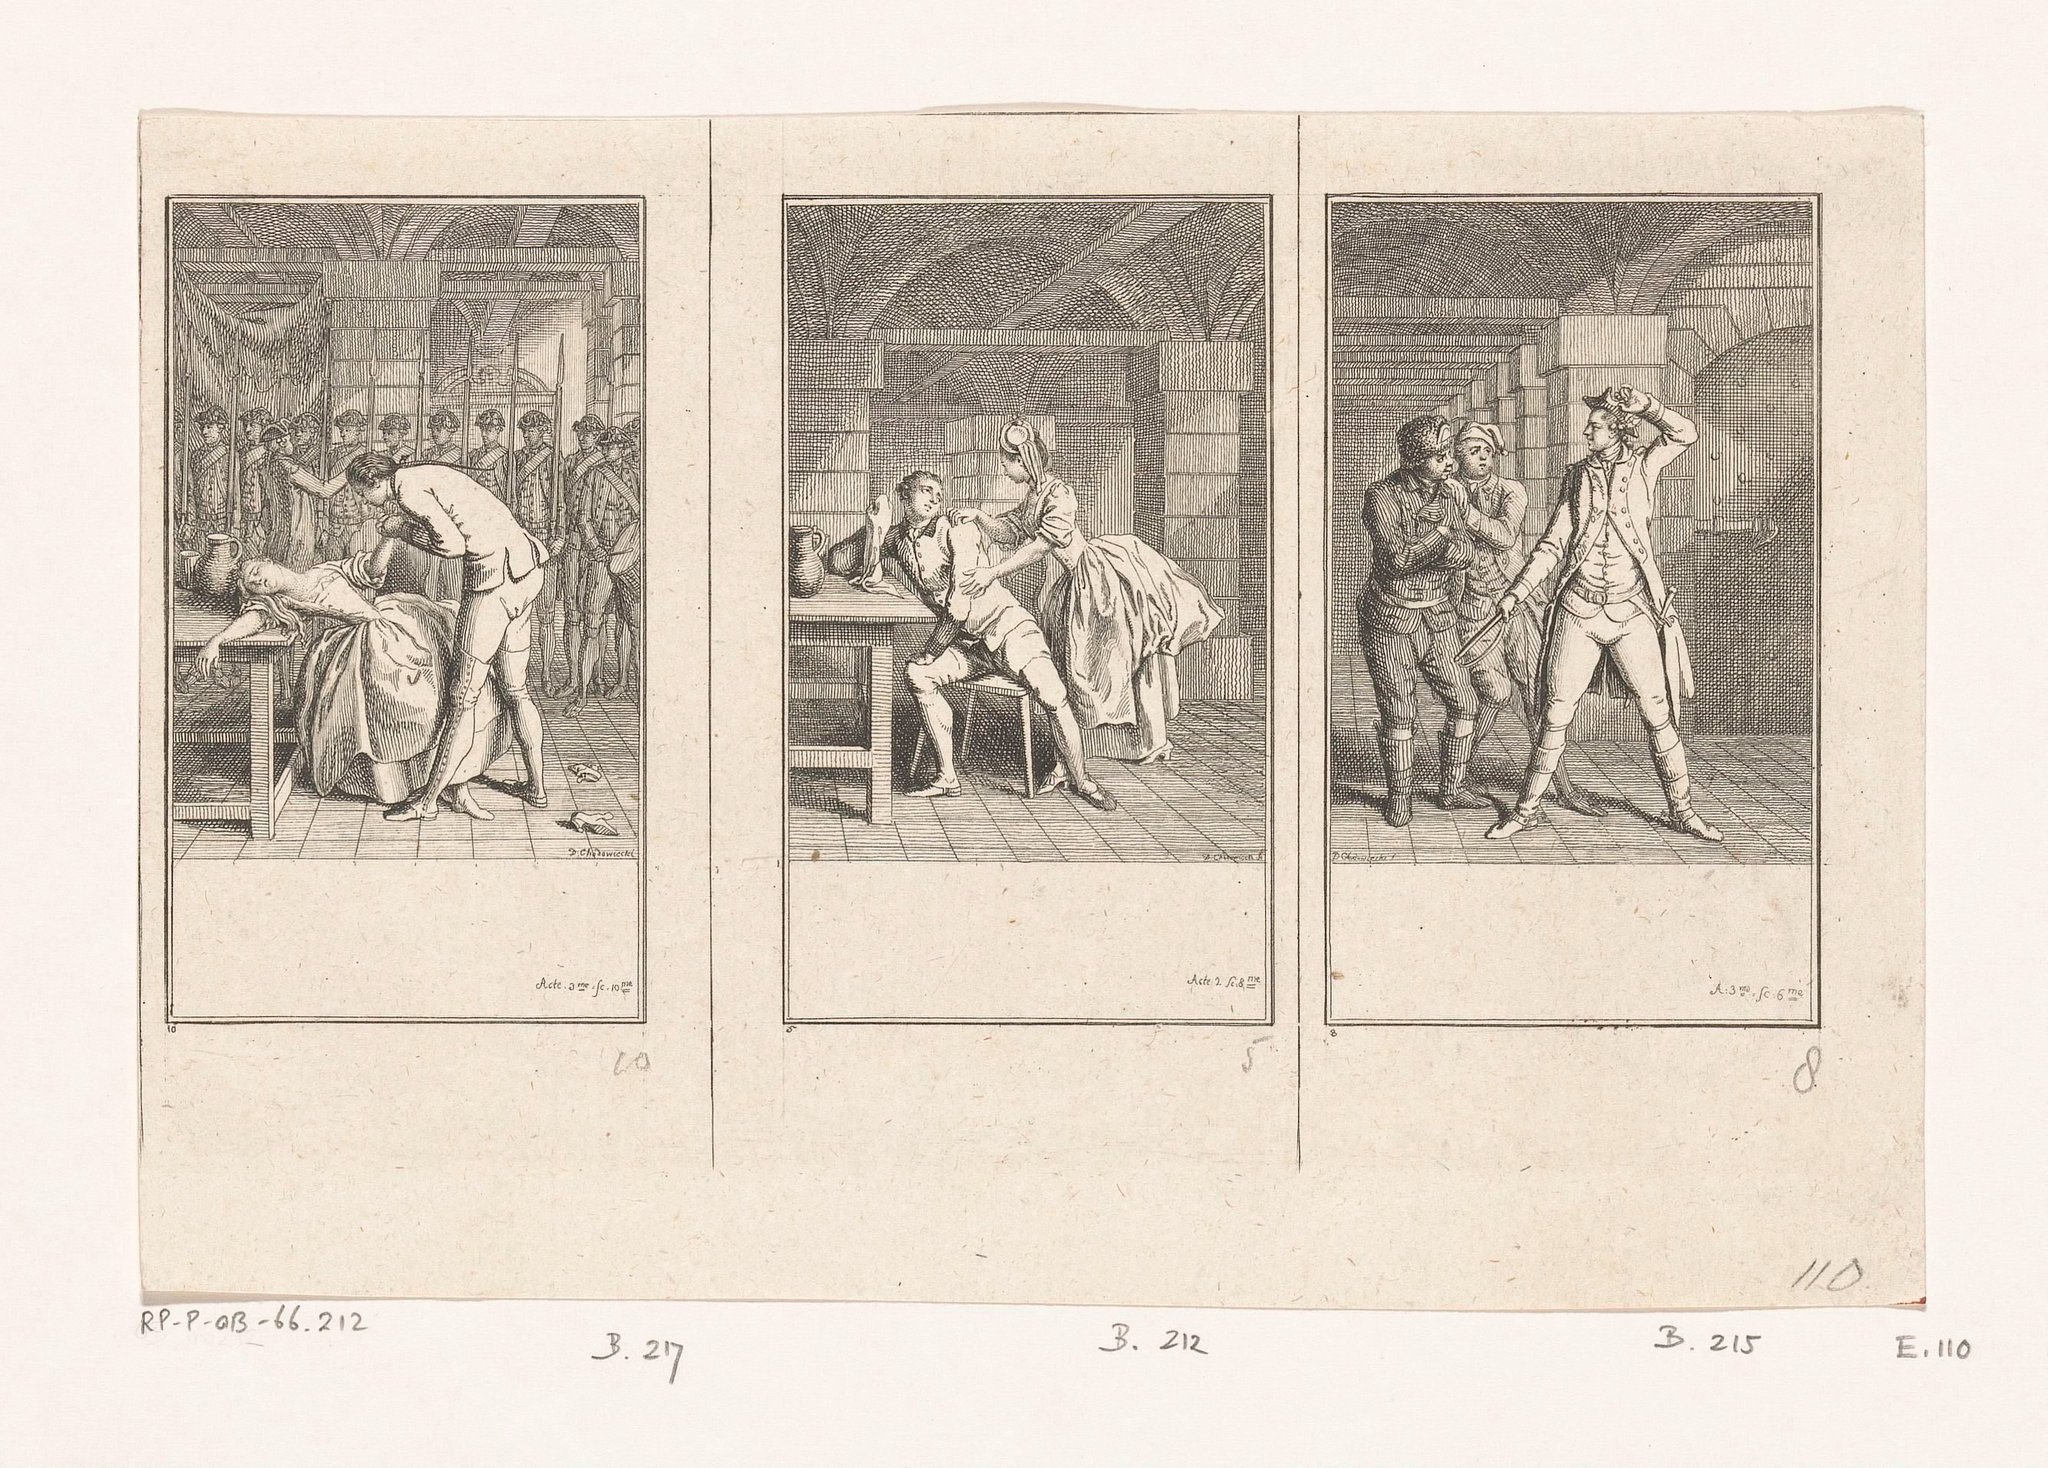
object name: print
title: Drie scènes uit de Deserteur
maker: daniel nikolaus chodowiecki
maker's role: draughtsman, print maker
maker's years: 1726-1801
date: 1774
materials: paper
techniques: etching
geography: berlin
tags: paris, prison, jail, fainting, swooning, literature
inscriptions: collector's mark: Lugt 240, collector's mark: Lugt 700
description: Tiende, vijfde en achtste scène uit een serie van twaalf scènes die de opéra comique 'Le déserteur' door Michel-Jean Sedaine illustreren. De scènes werden op een plaat geëtst. De tweede staat van deze serie werd ook gebruikt in: 'Berliner genealogischen Calender auf das Jahr 1775'.